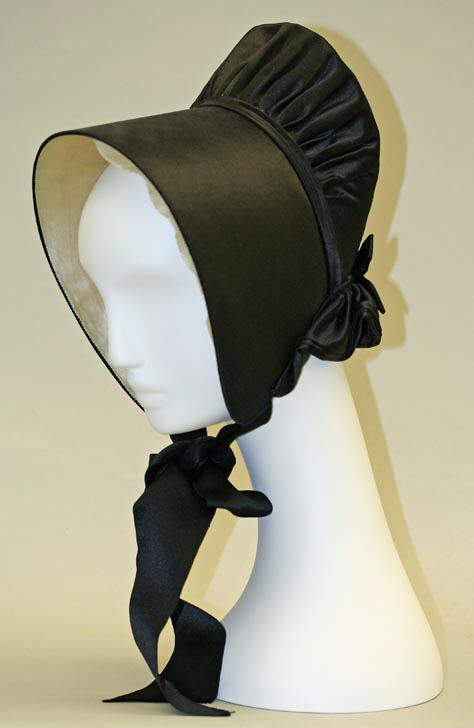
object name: bonnet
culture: american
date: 1801-1900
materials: silk